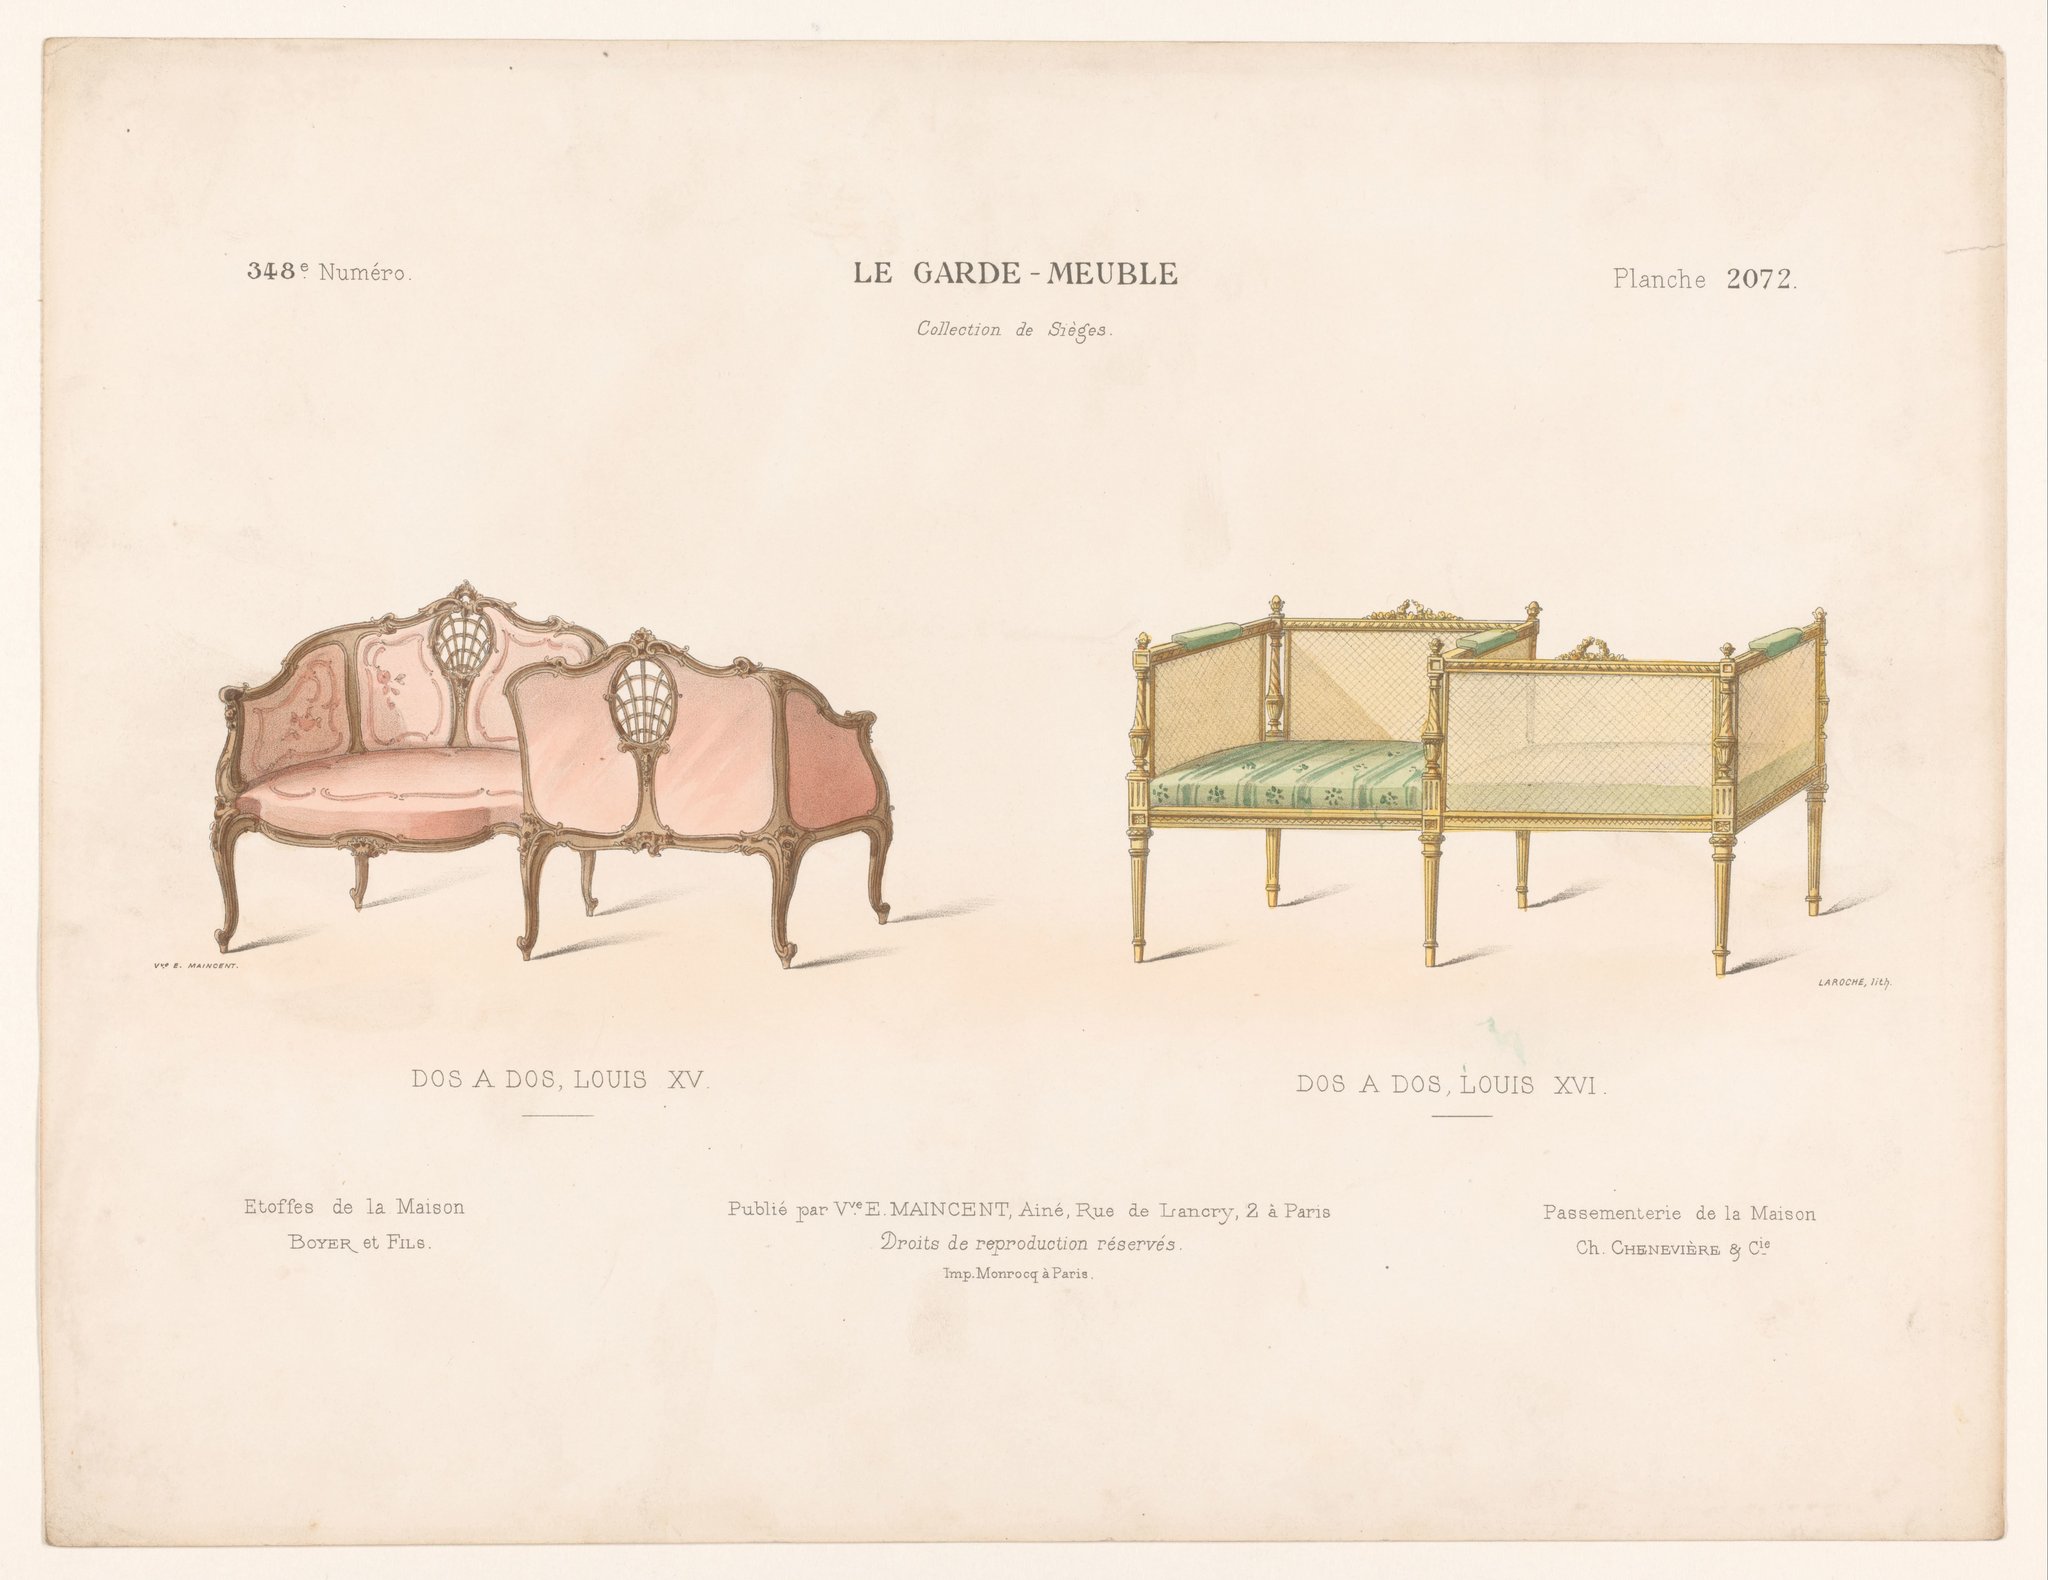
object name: print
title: Dos a dos, Louis XV / Dos a dos, Louis XVI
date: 1895-1935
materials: paper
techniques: hand coloring, lithograph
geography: paris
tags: seating furniture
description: Ieder Livraison in de serie Le Garde-Meuble bevat negen platen: drie 'sièges' (zitmeubels), drie 'meubles' (diverse meubels zoals tafels en kasten) en drie 'tentures' (gordijnen en draperieën).